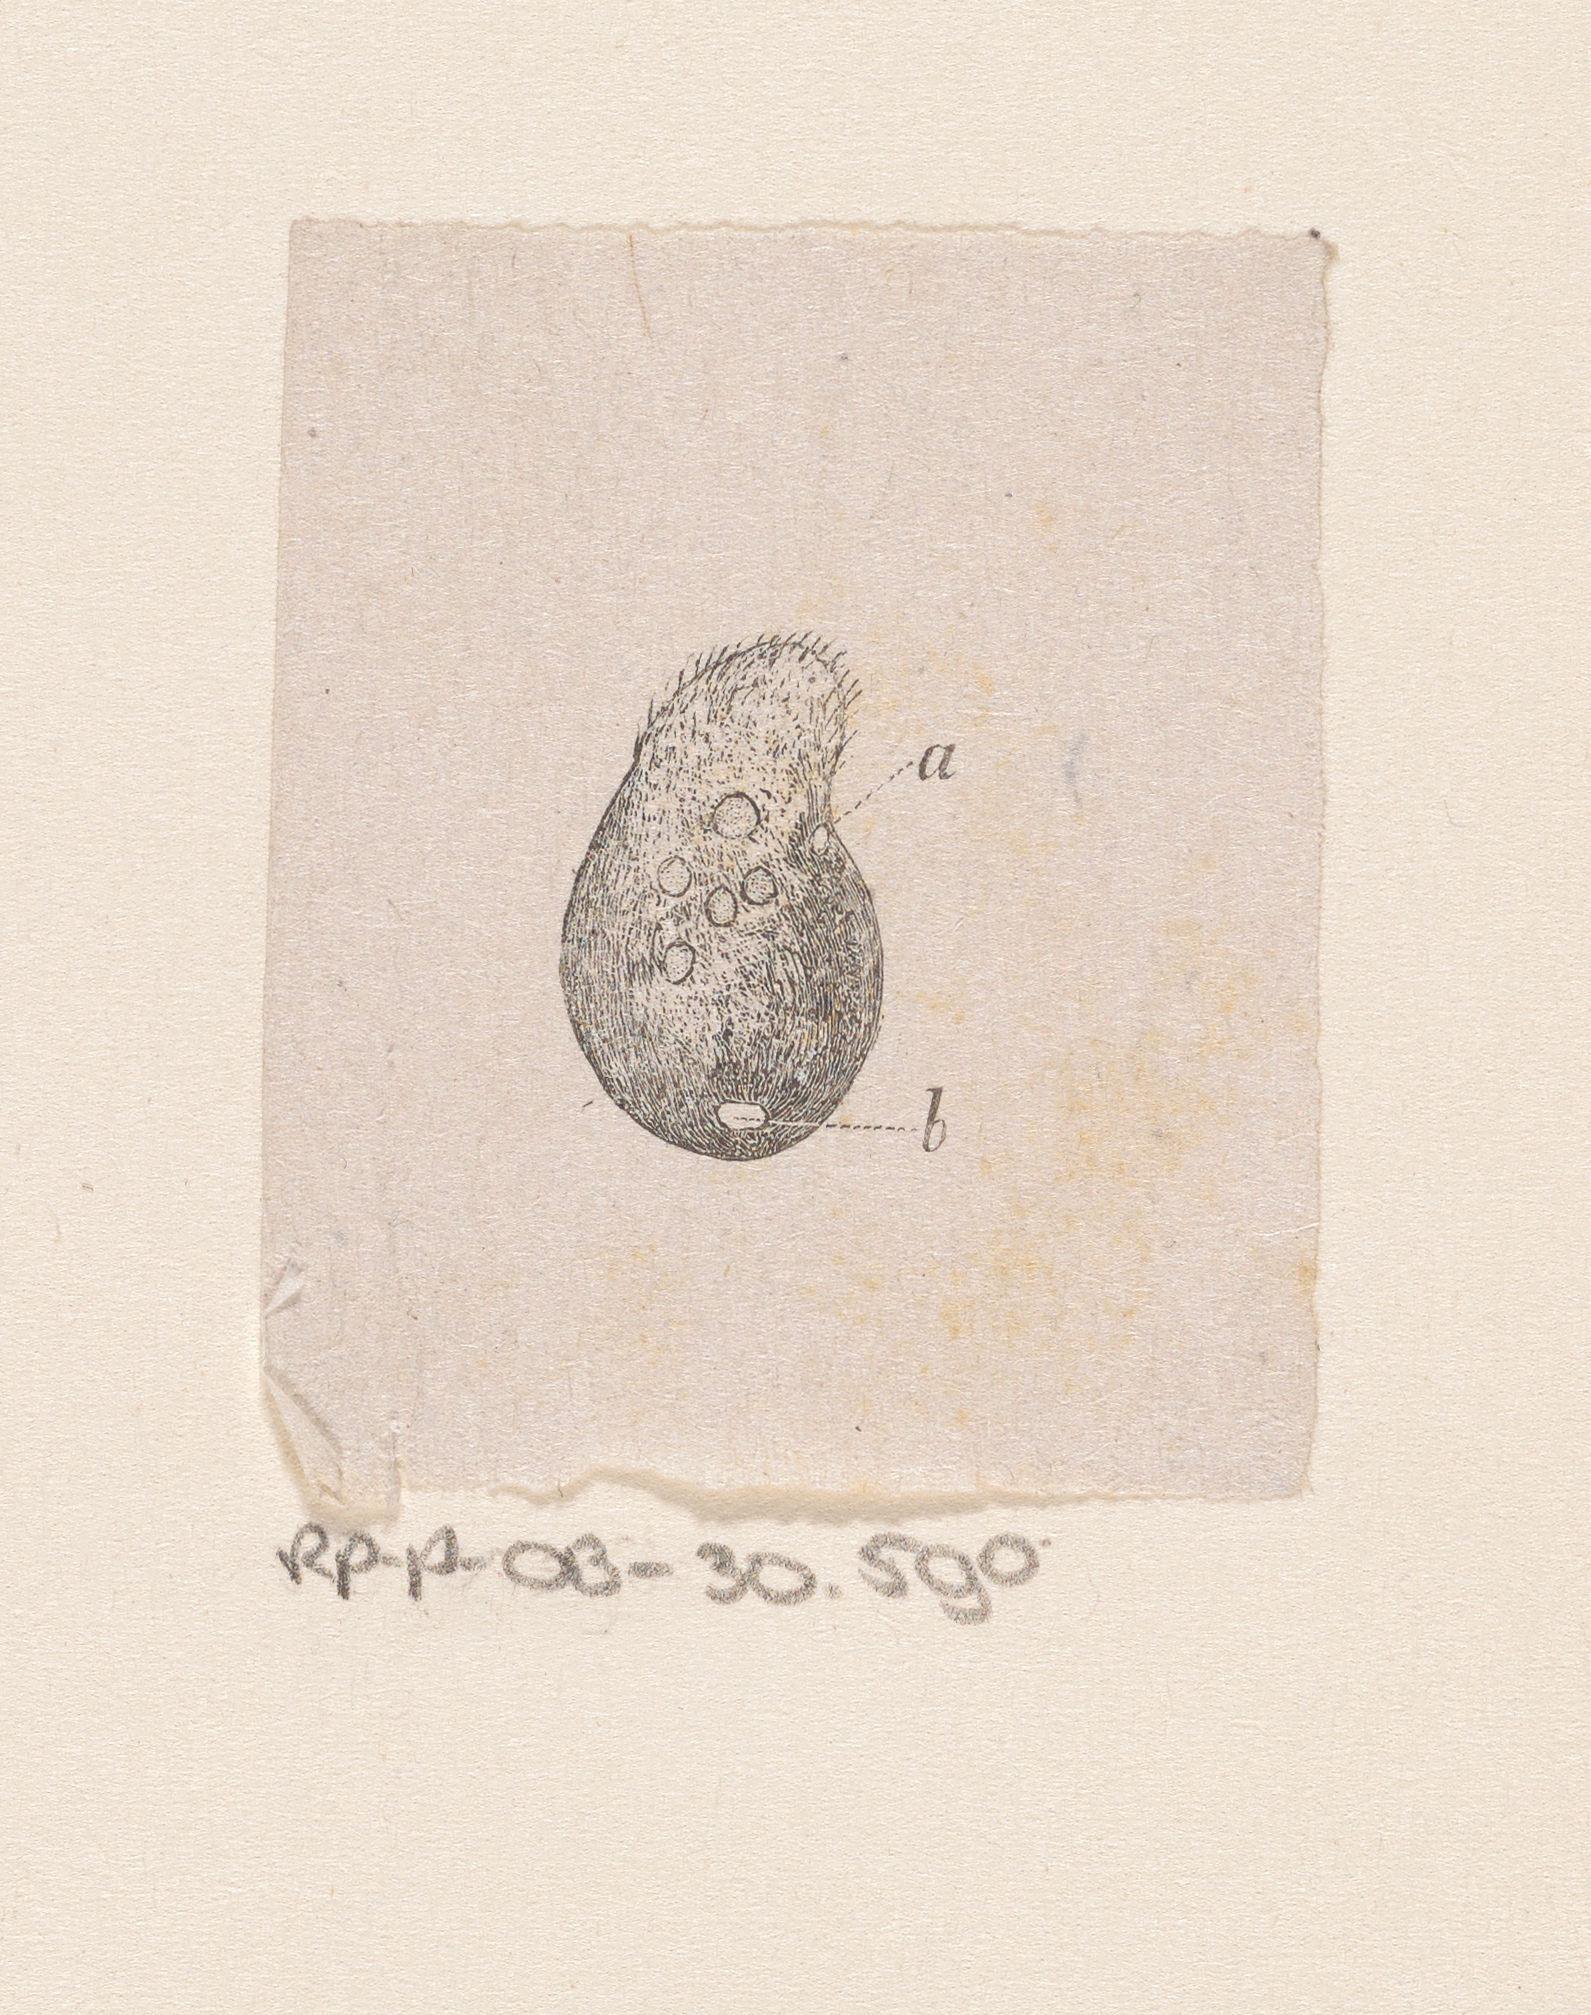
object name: print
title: Onderdeel van het menselijk lichaam met een afwijking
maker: isaac weissenbruch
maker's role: print maker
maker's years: 1826-1912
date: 1836-1912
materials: paper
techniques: engraving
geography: netherlands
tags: anatomy (non-medical), diseases